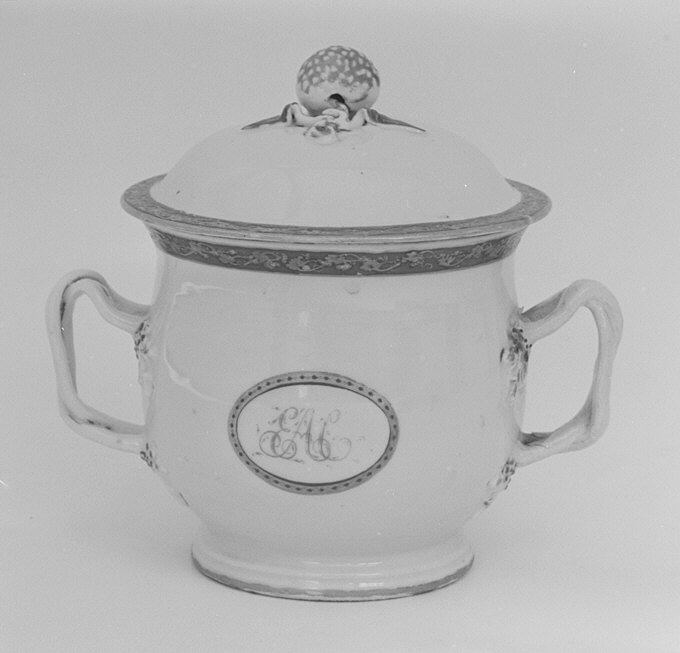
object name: sugar bowl with cover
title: Sugar bowl with cover (part of a service)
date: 1790-1800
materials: hard paste porcelain